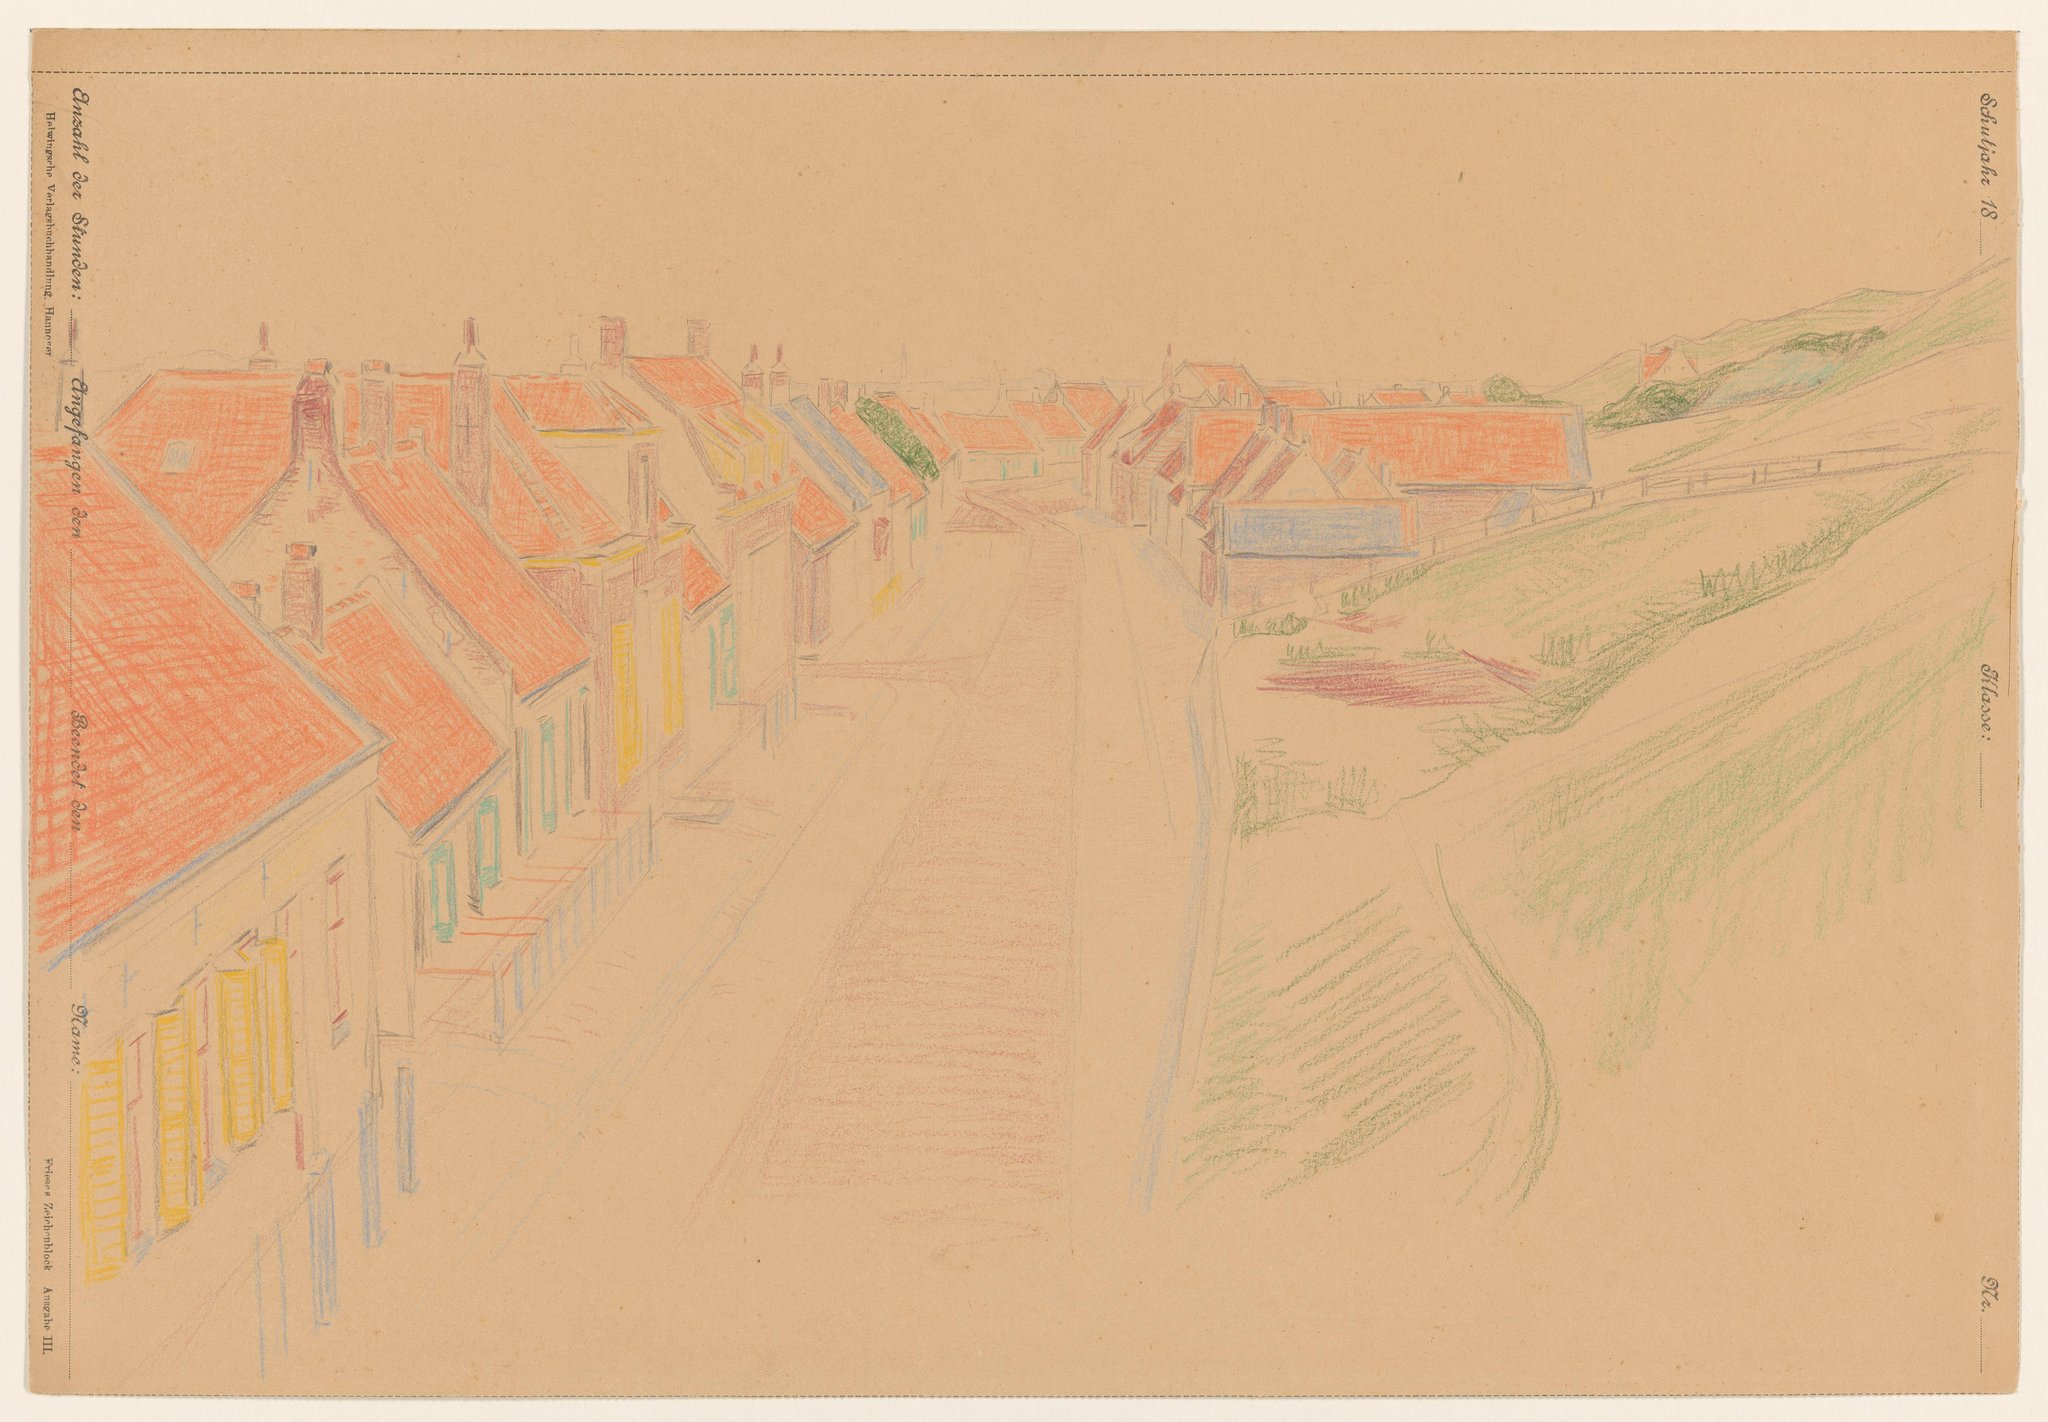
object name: drawing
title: Gezicht in een straatje van Zoutelande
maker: ferdinand hart nibbrig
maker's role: draughtsman, painter, print maker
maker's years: 1866-1915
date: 1876-1915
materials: paper, pencil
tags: peninsula